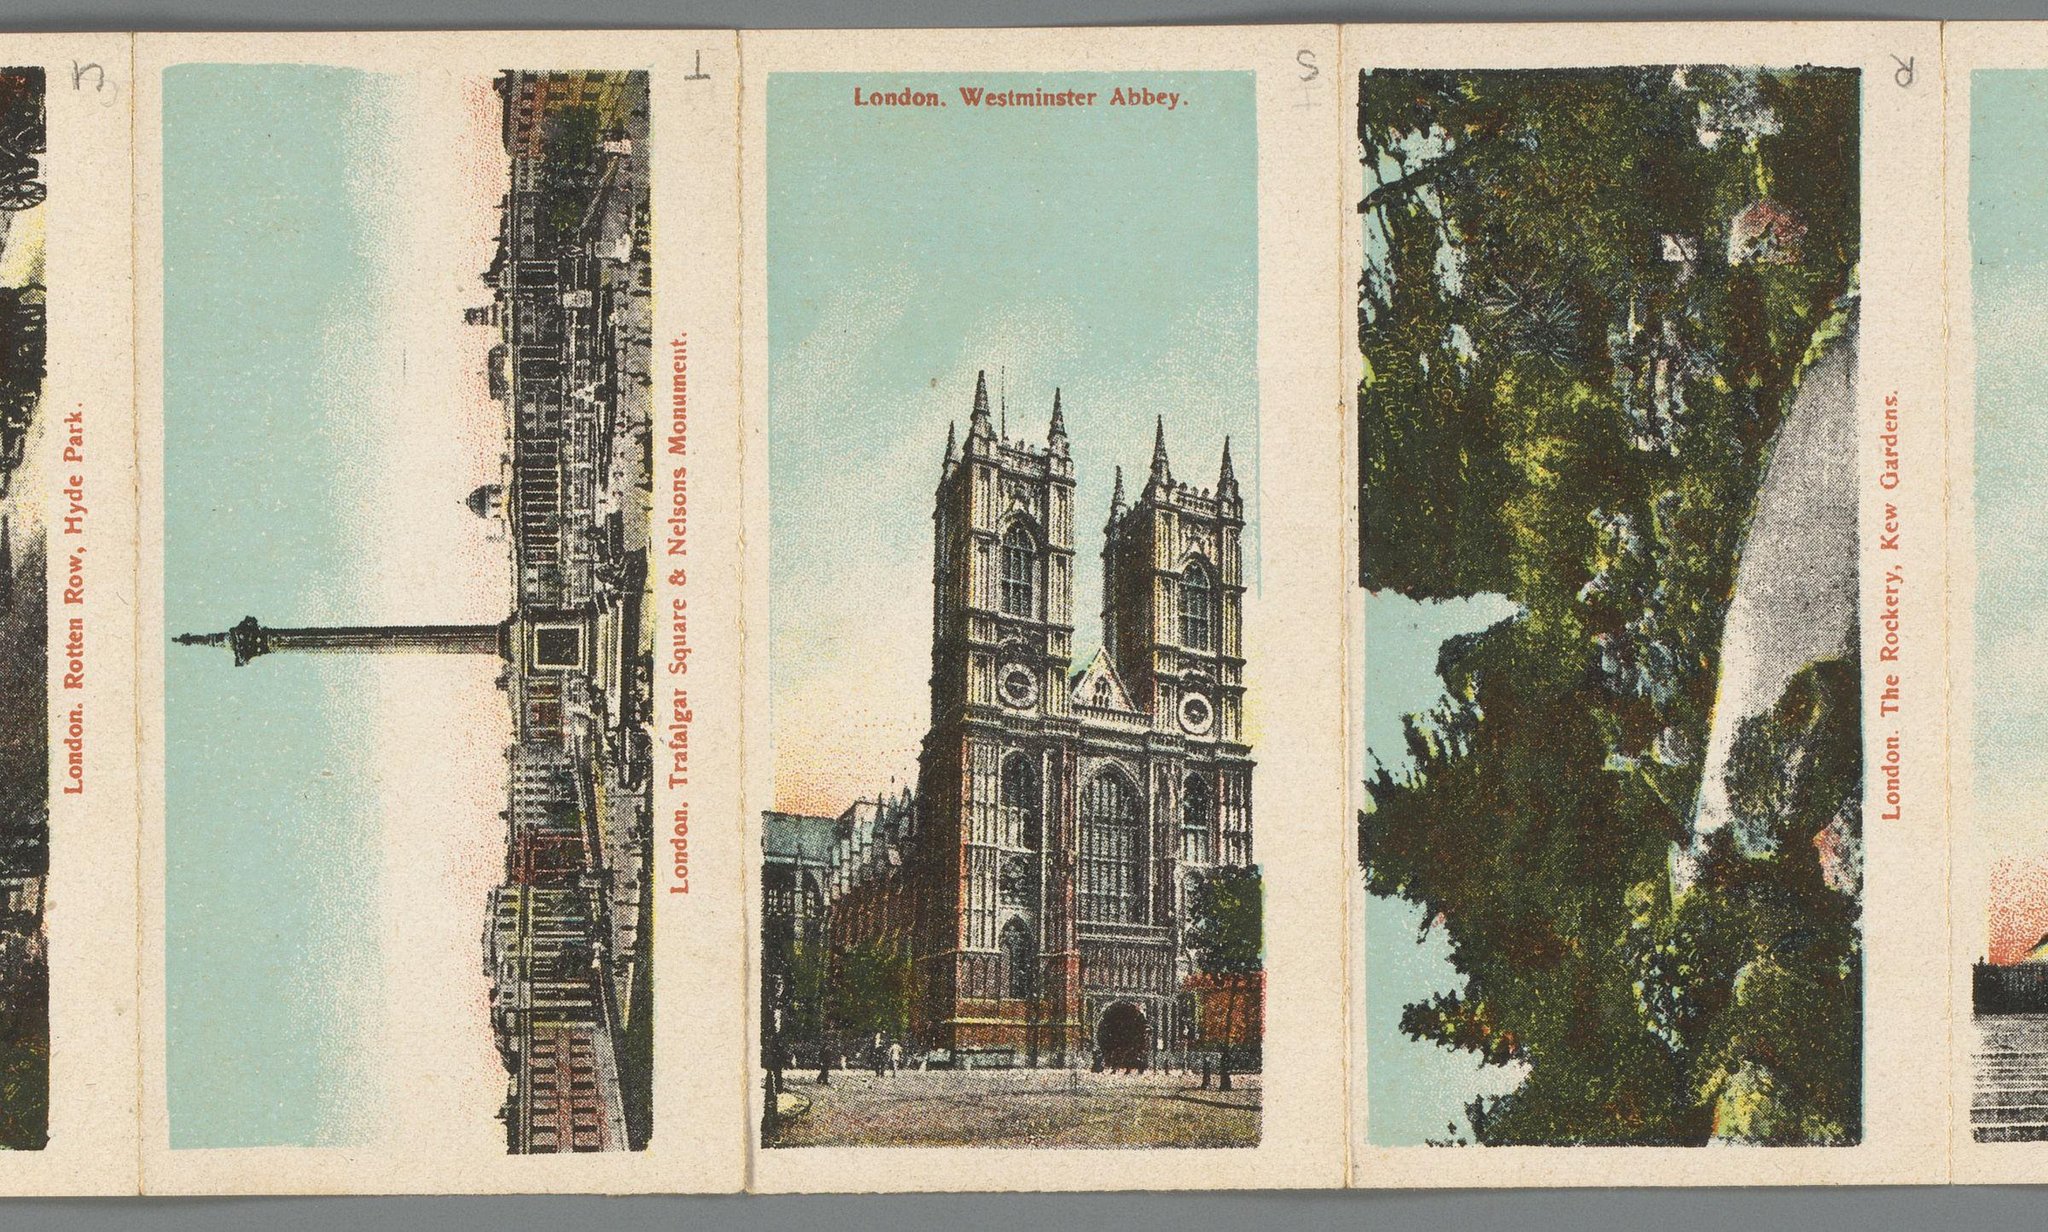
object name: photomechanical print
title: Façade van Westminster Abbey, Londen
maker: Anonymous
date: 1888-1914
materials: paper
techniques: autotype, chromophotolithography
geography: london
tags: parts of church exterior and annexes: façade, westminster abbey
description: Deze prent maakt deel uit van een album.